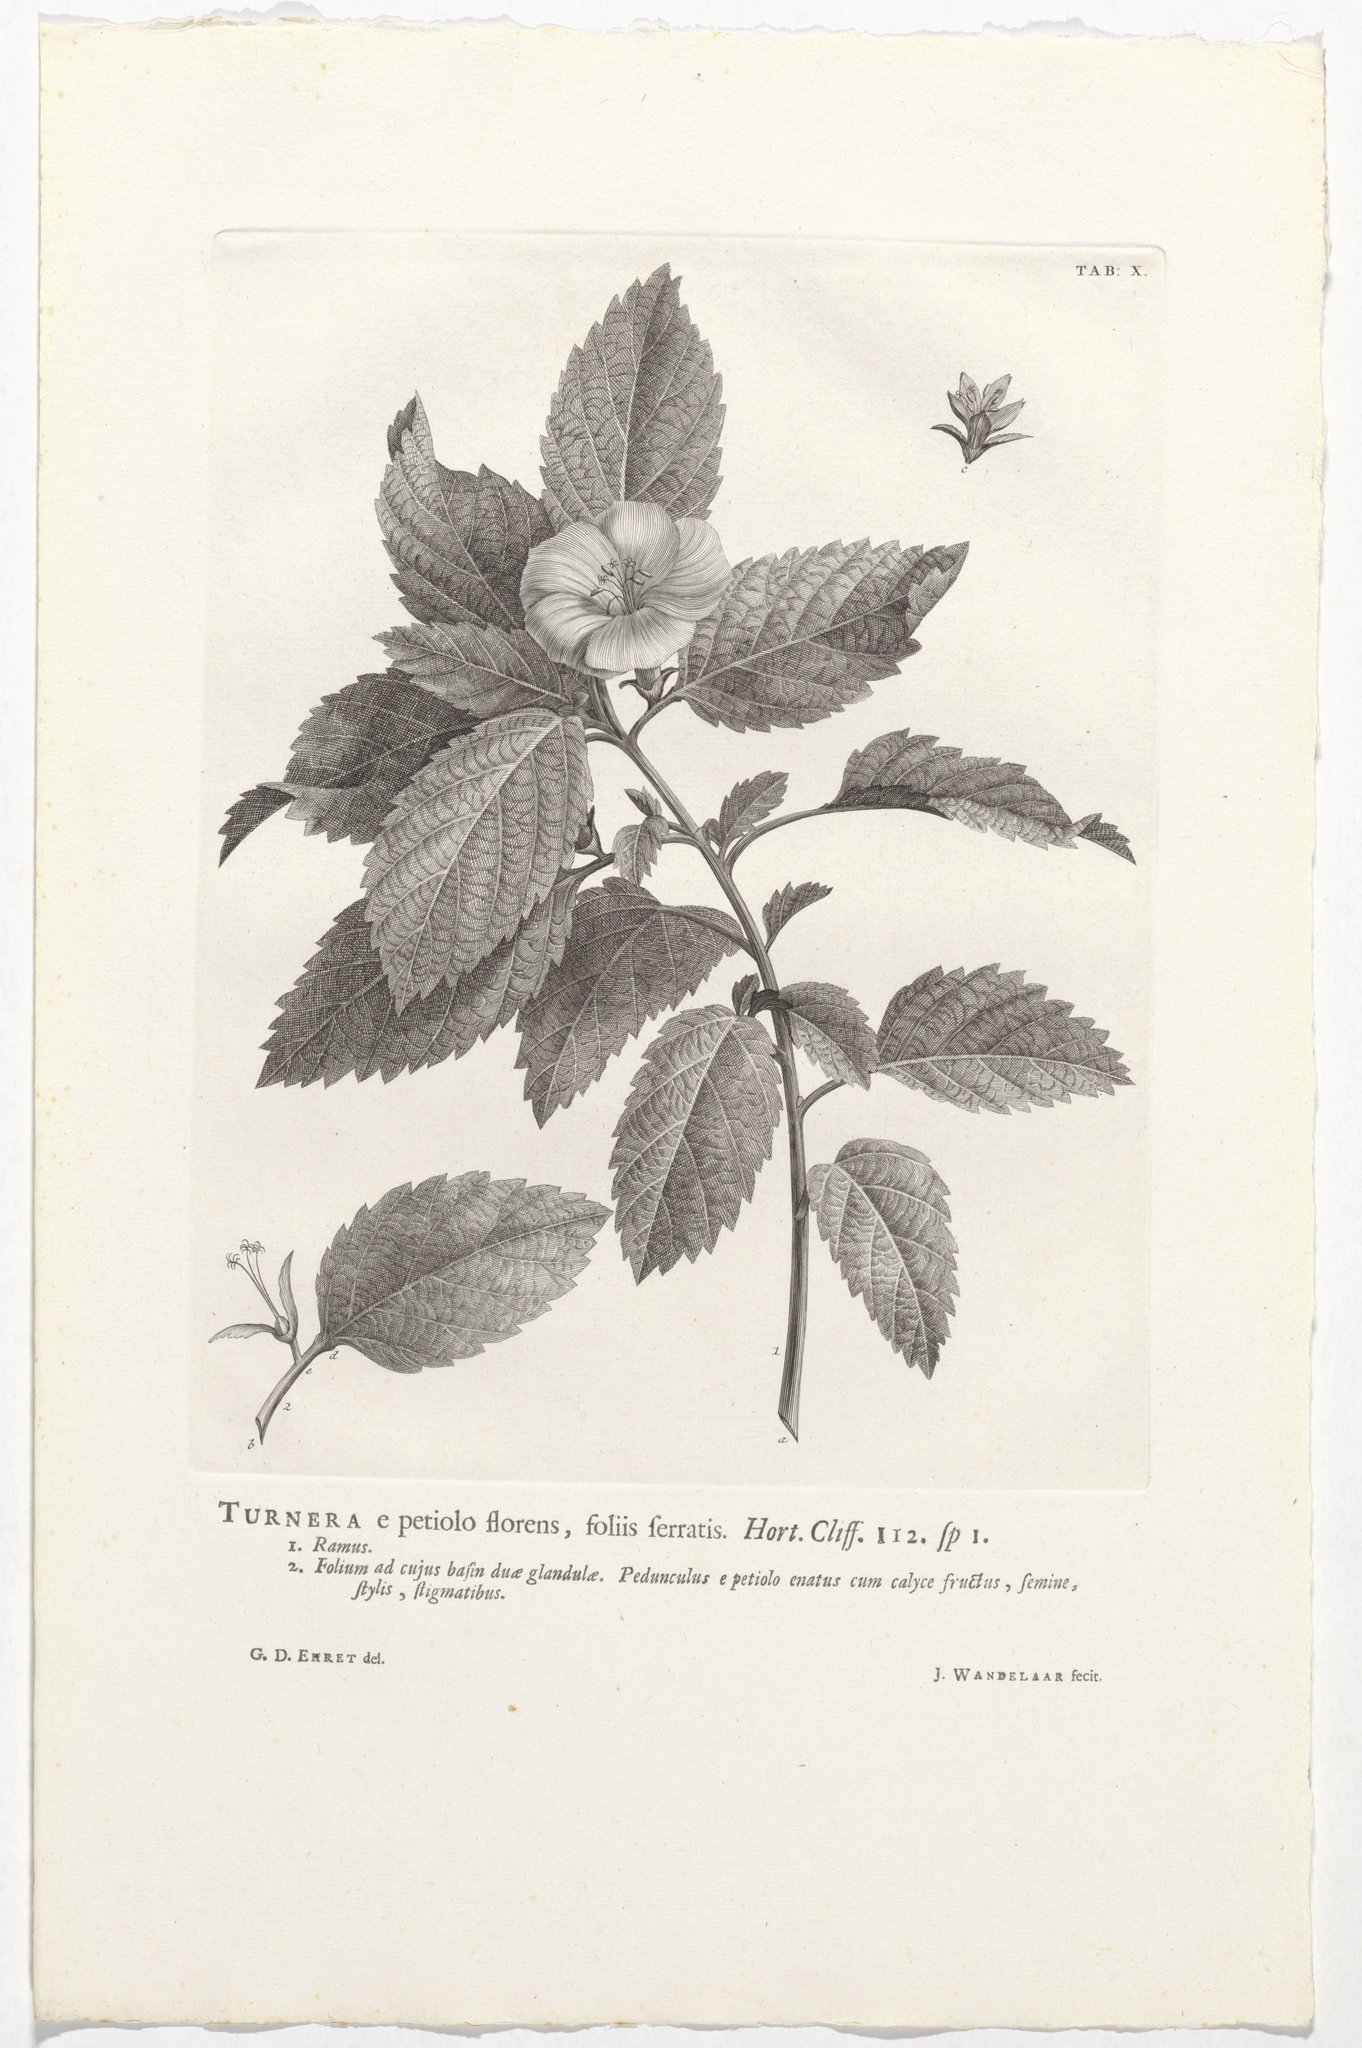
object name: print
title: Turnera e petiolo florens, foliis serratis. Hort. Cliff. 112. sp. 1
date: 1738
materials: paper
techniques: etching, letterpress printing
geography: warmond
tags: flowers, plants and herbs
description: Prent gebruikt als illustratie in: Linnaeus, Carolus. Hortus Cliffortianus plantas exhibens quas in hortis tam vivis quam siccis, Hartecampi in Hollandia, coluit (...) Georgius Clifford. Amsterdam: sine nomen, 1738.